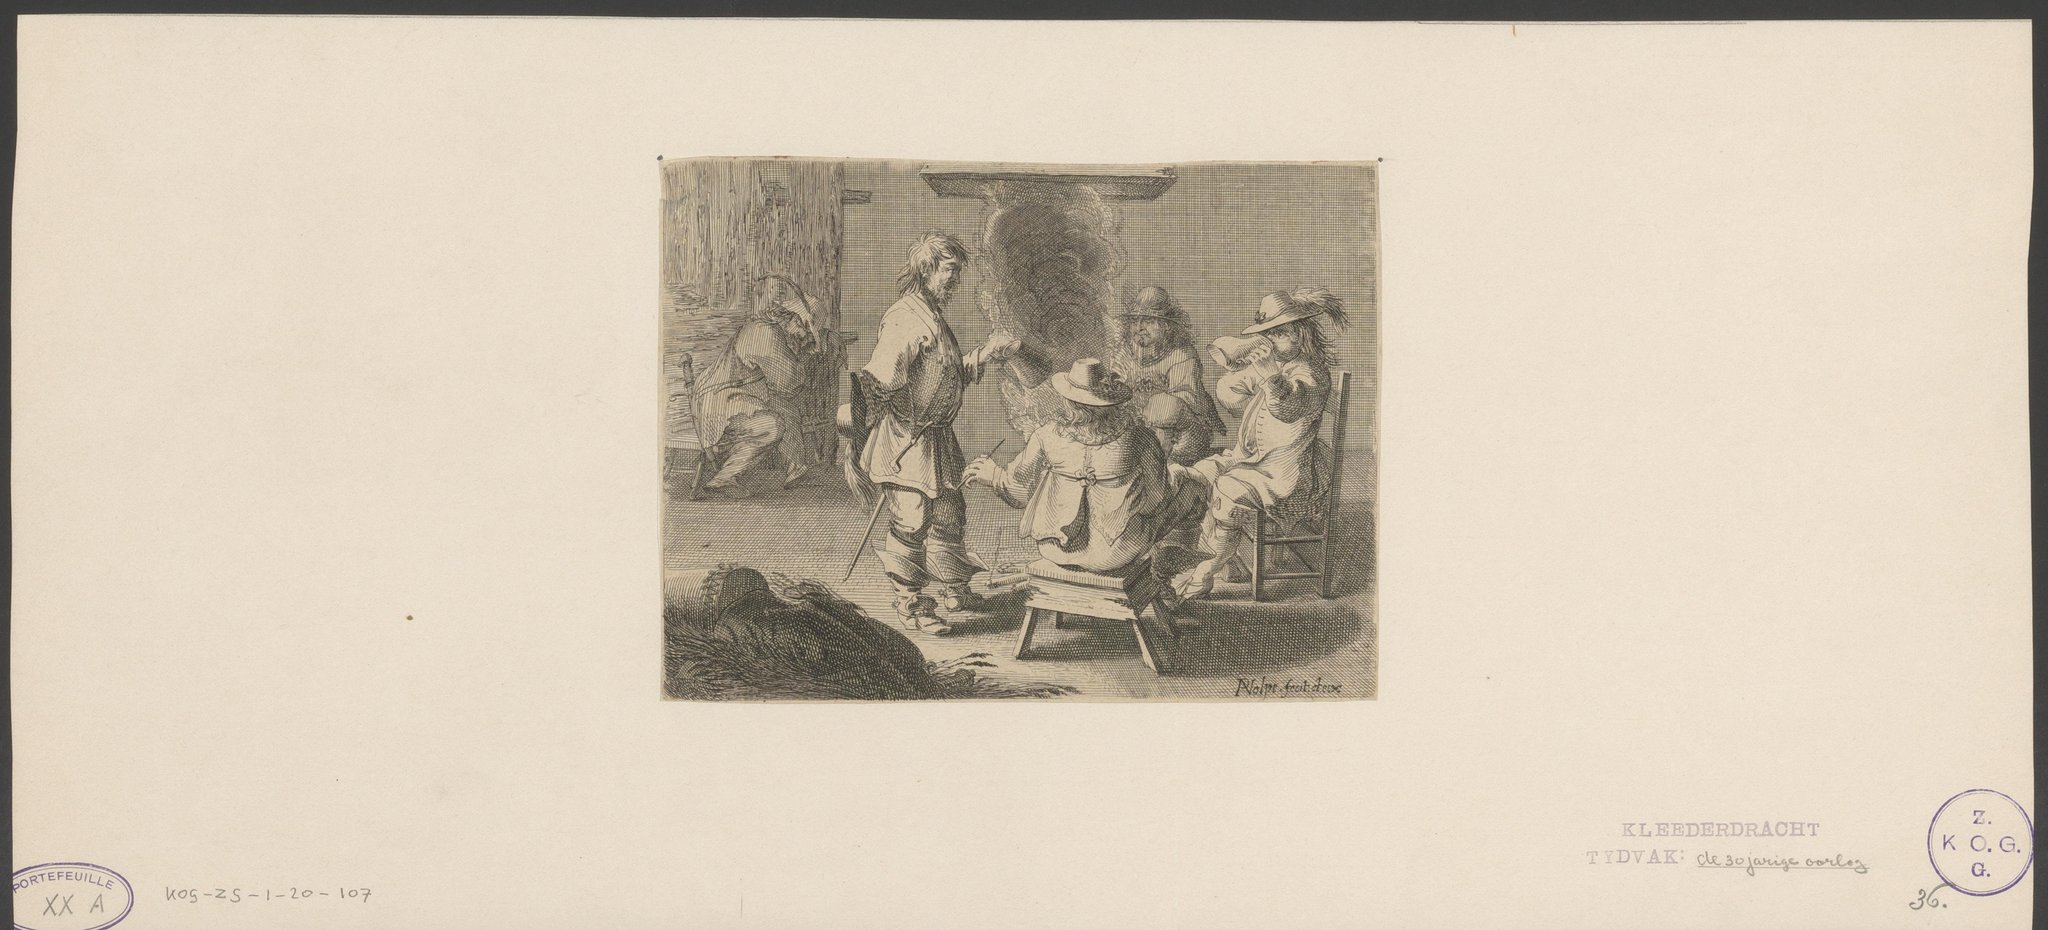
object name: print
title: Mannen rond een vuur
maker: pieter nolpe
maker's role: draughtsman, print maker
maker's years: 1613-1653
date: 1623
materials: paper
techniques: engraving, etching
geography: amsterdam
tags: sleeping in chair, pipe ~ tobacco, jar, jug (used as drinking-vessel), open hearth, fire-place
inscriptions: stamp, stamp, collector's mark: Lugt 1641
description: Rond een vuur in een interieur zitten vier mannen, waarvan er twee een kruik in de handen hebben. De man op de rug gezien rookt pijp. Linksachter is een man op een bankje in slaap gevallen. Onderwerpsrubrieken binnen de Atlas Zeden en Gewoonten: Zeden en Gewoonten in Engeren Zin, De Kleeding, Kleederdrachten (tijdvakken), De 30-jarige oorlog. (1600 – 1650).